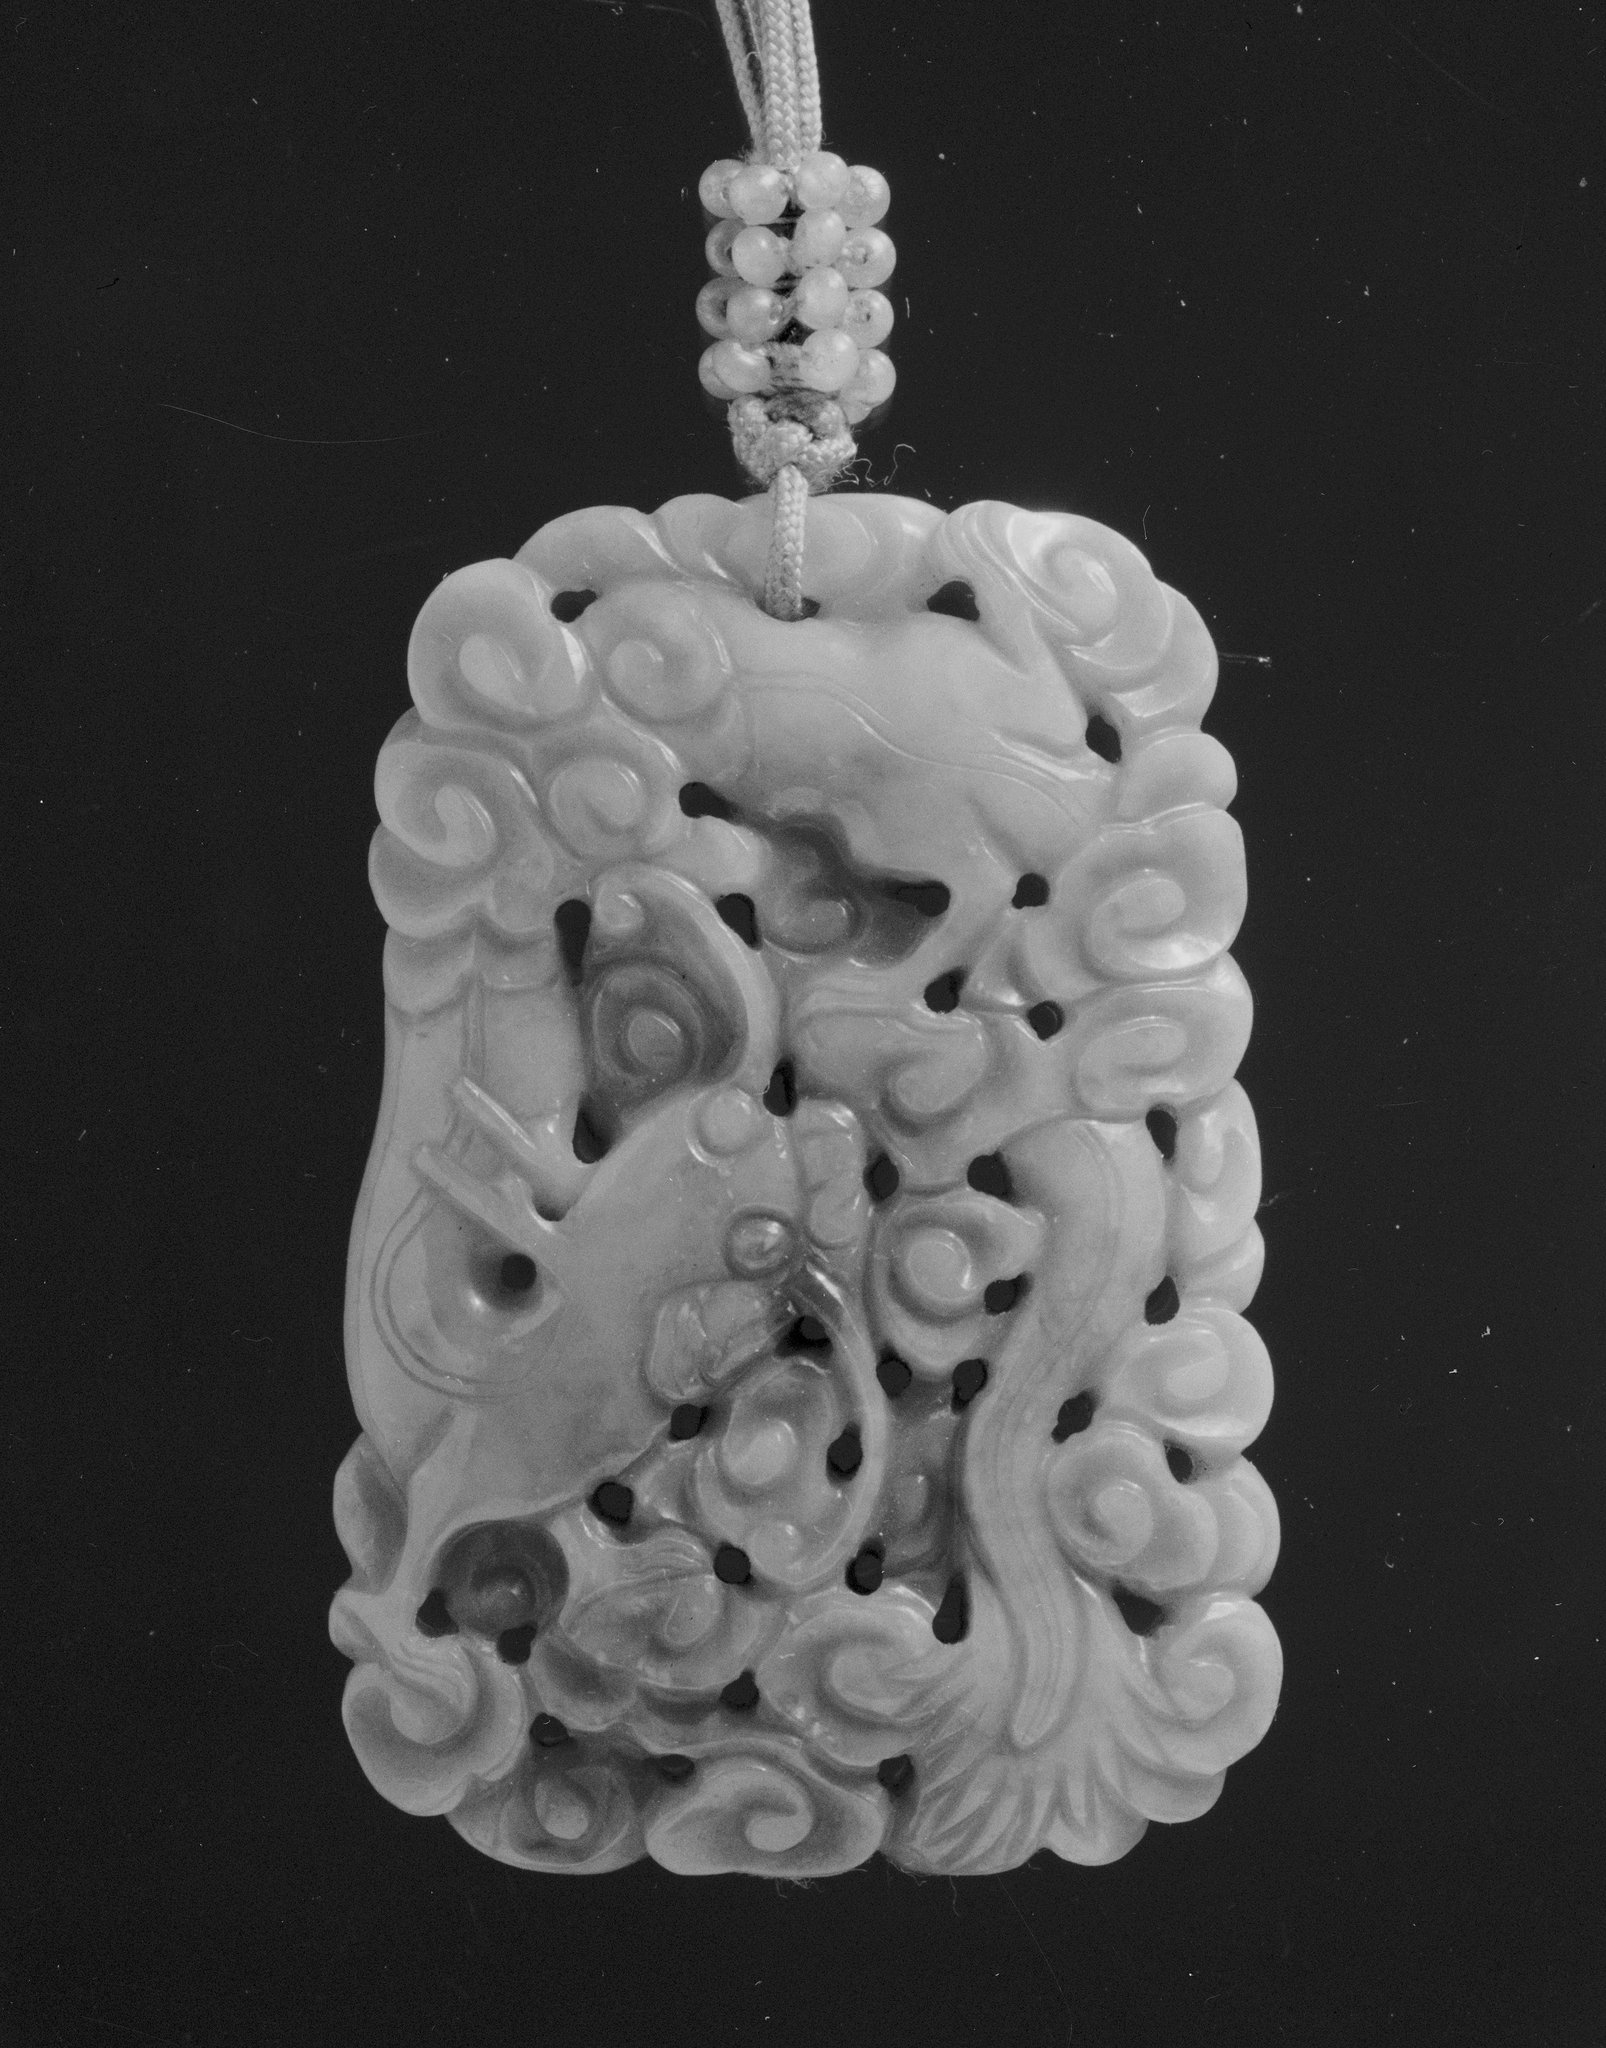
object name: pendant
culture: chinese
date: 1901-2000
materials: jade, pearl